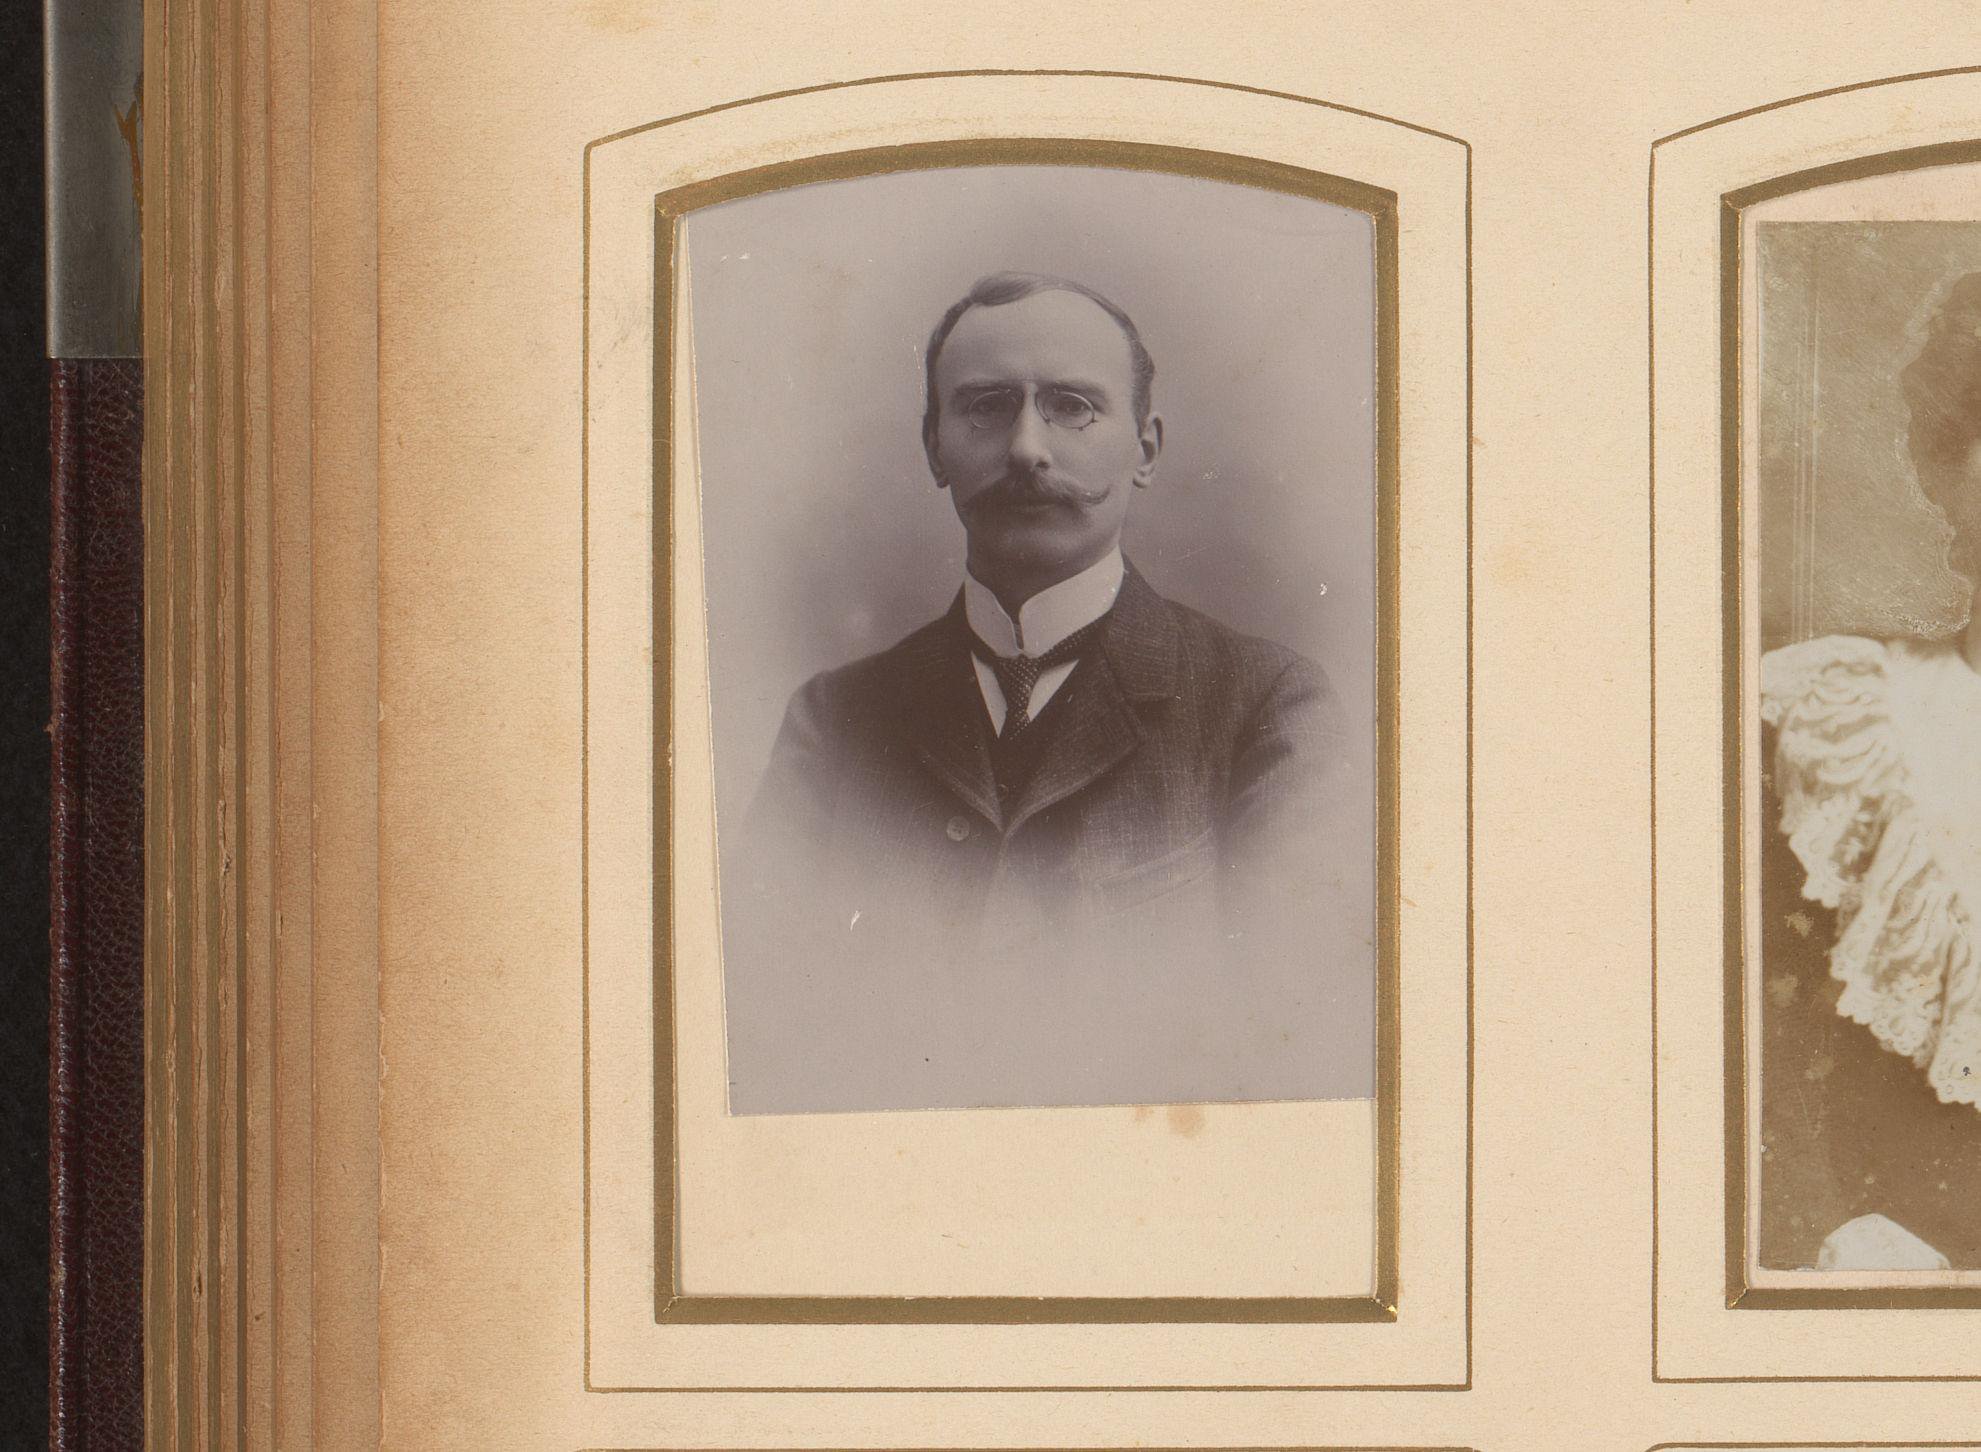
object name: album leaf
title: Portret van een man met snor en bril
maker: Anonymous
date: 1880-1920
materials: cardboard, photographic support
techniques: collodion silver print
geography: netherlands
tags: eyeglasses, spectacles, moustache, historical persons